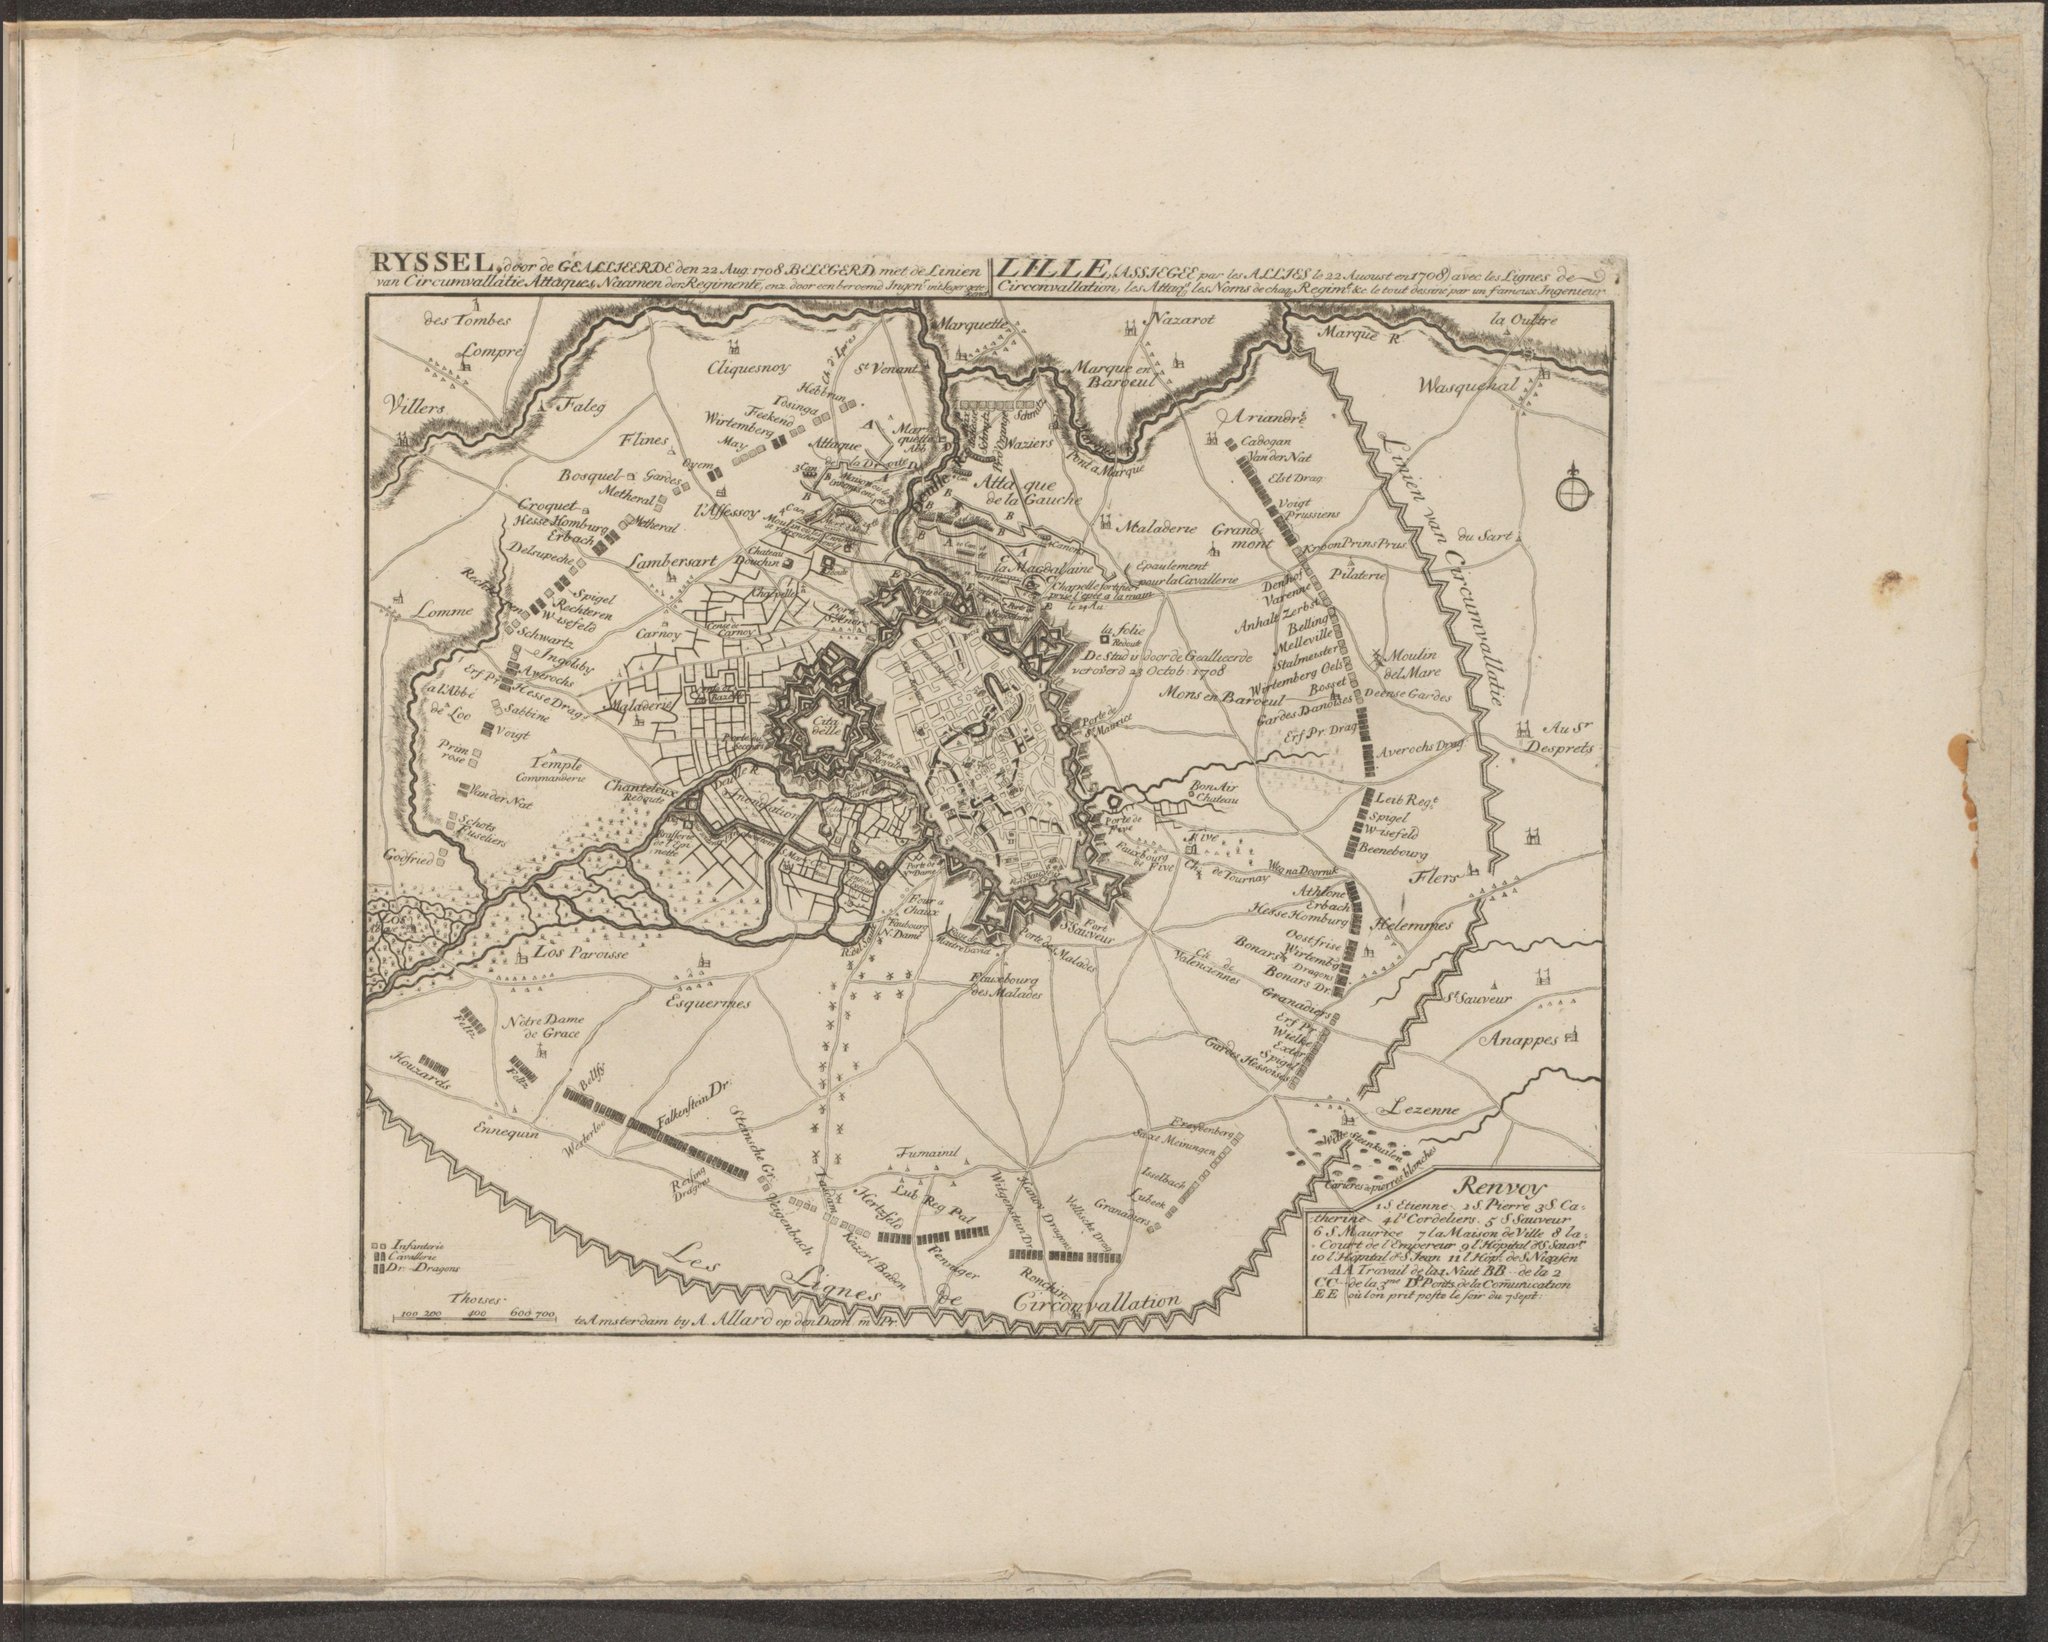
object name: album leaf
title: Les Principales Forteresses & Villes Fortes, d'Espagne, de France, d'Italie, de Savoië, d'Allemagne & des Païs-Bas (...) / Naaukeurige Afbeeldingen der Voornaamste Sterke Steden en Vestingen in Spanjen, Vrankryk, Italien, Savoyen, Duytsland en Nederlanden (...)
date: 1708-1733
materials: paper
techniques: etching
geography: leiden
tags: siege, position war, maps of cities, lille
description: Kaart van het beleg van Rijssel (Lille), ingenomen door de geallieerden op 22 augustus 1708. Met teksten in het Nederlands en Frans. De prent maakt deel uit van een album.